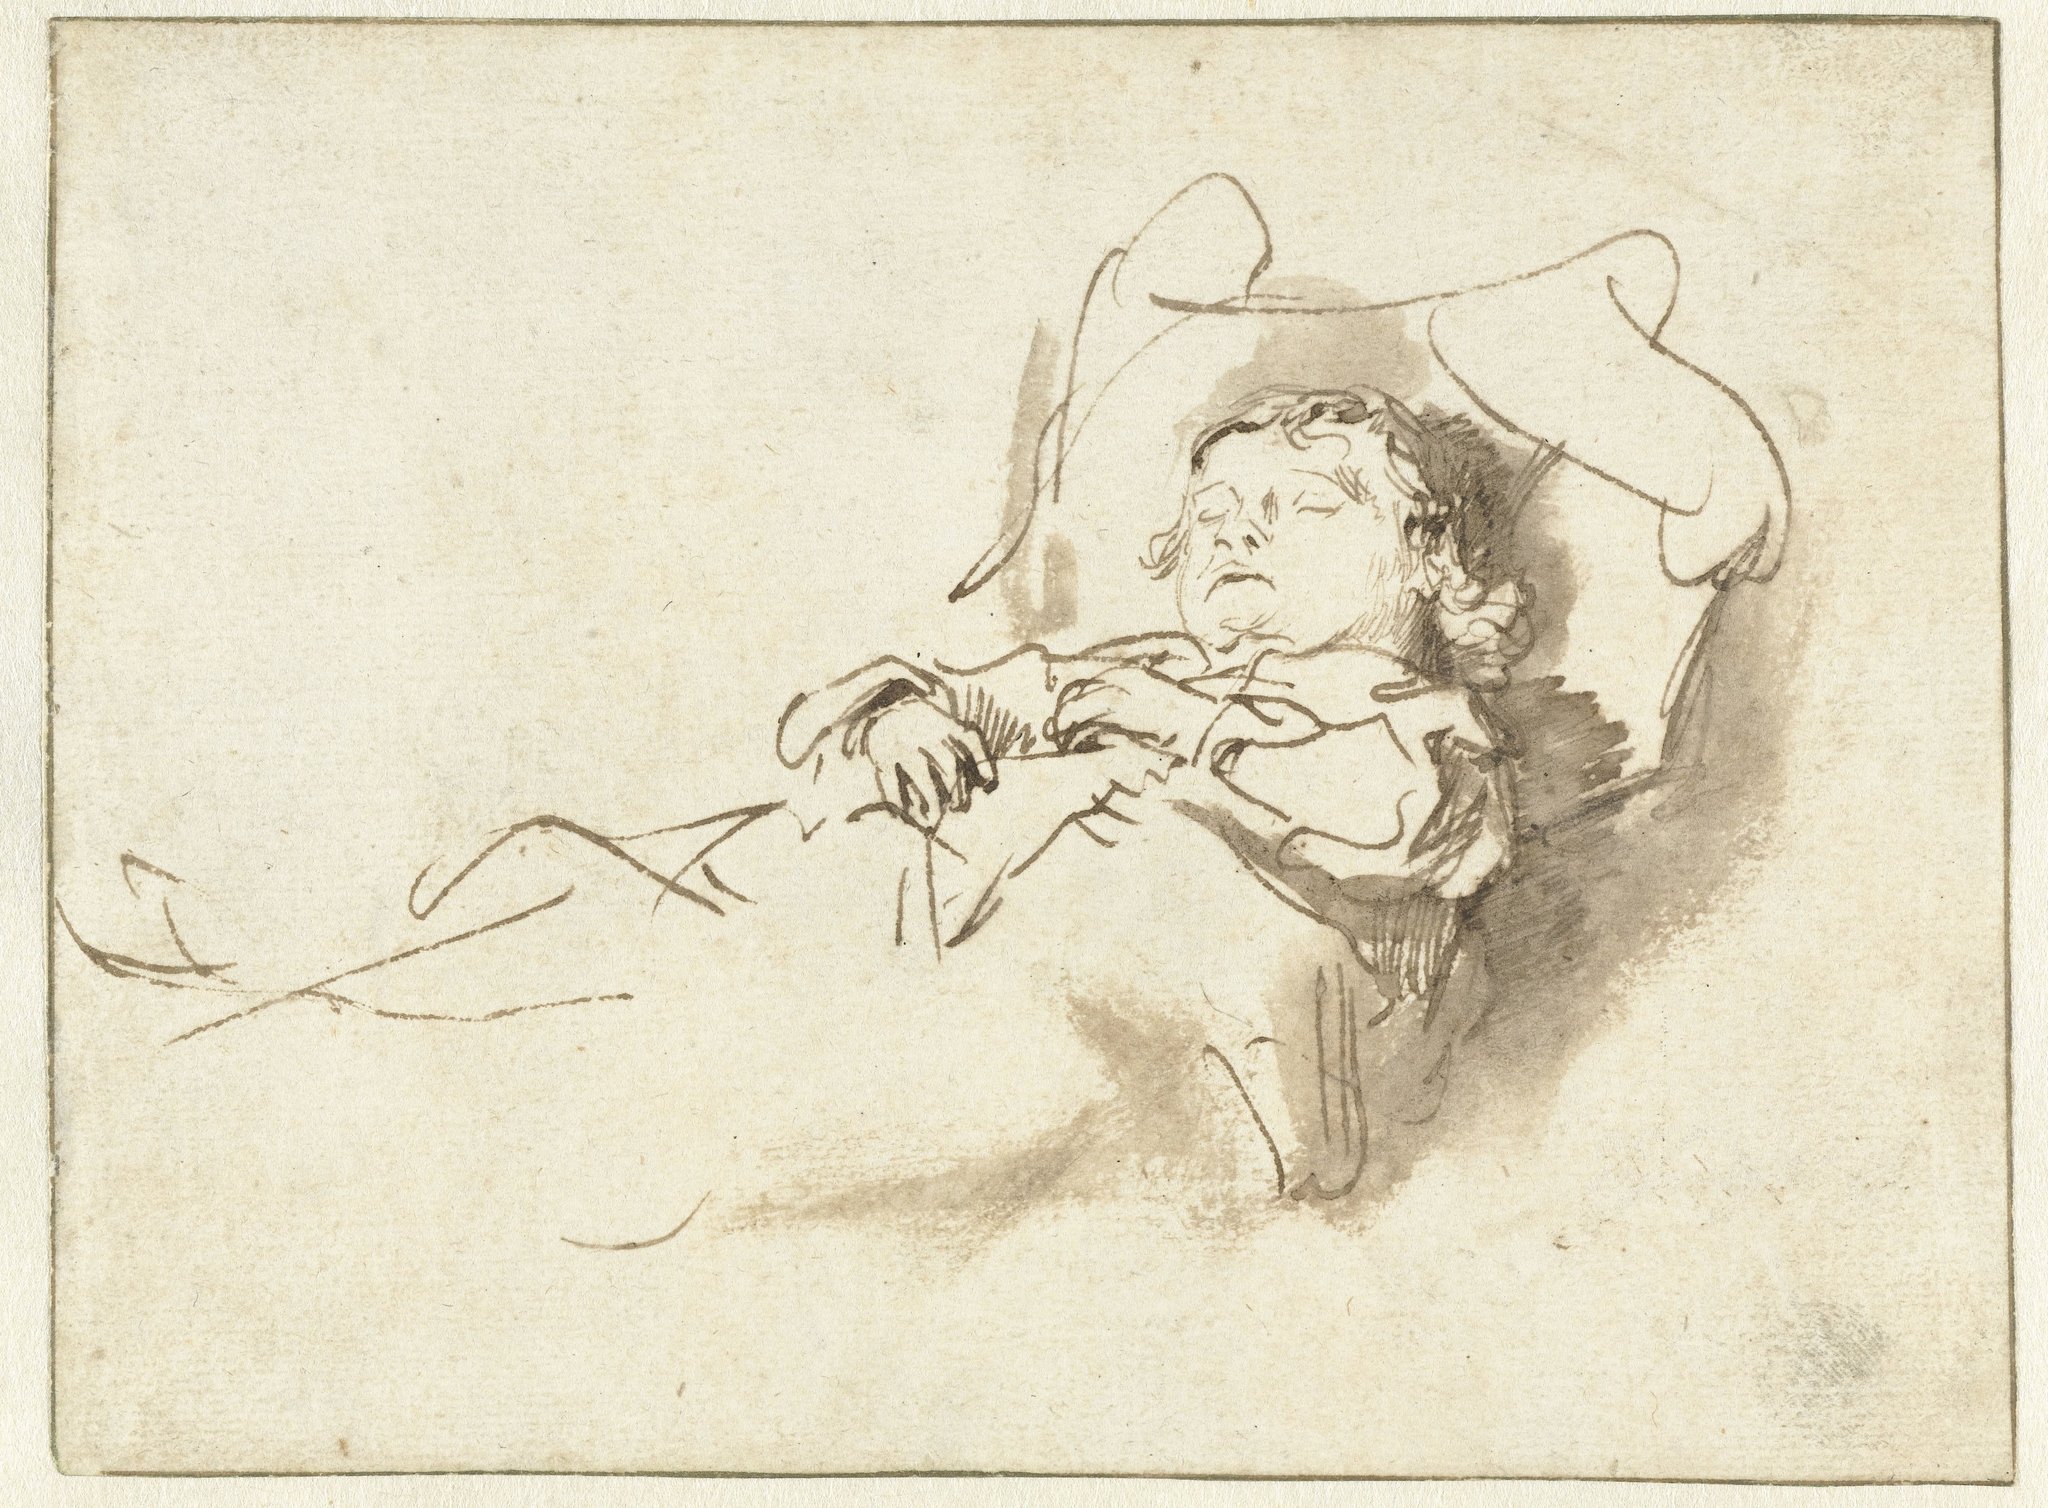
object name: drawing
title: Boy Sleeping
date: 1625-1675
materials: ink, paper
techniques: brush, pen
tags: boy (child between toddler and youth), sleeping in bed